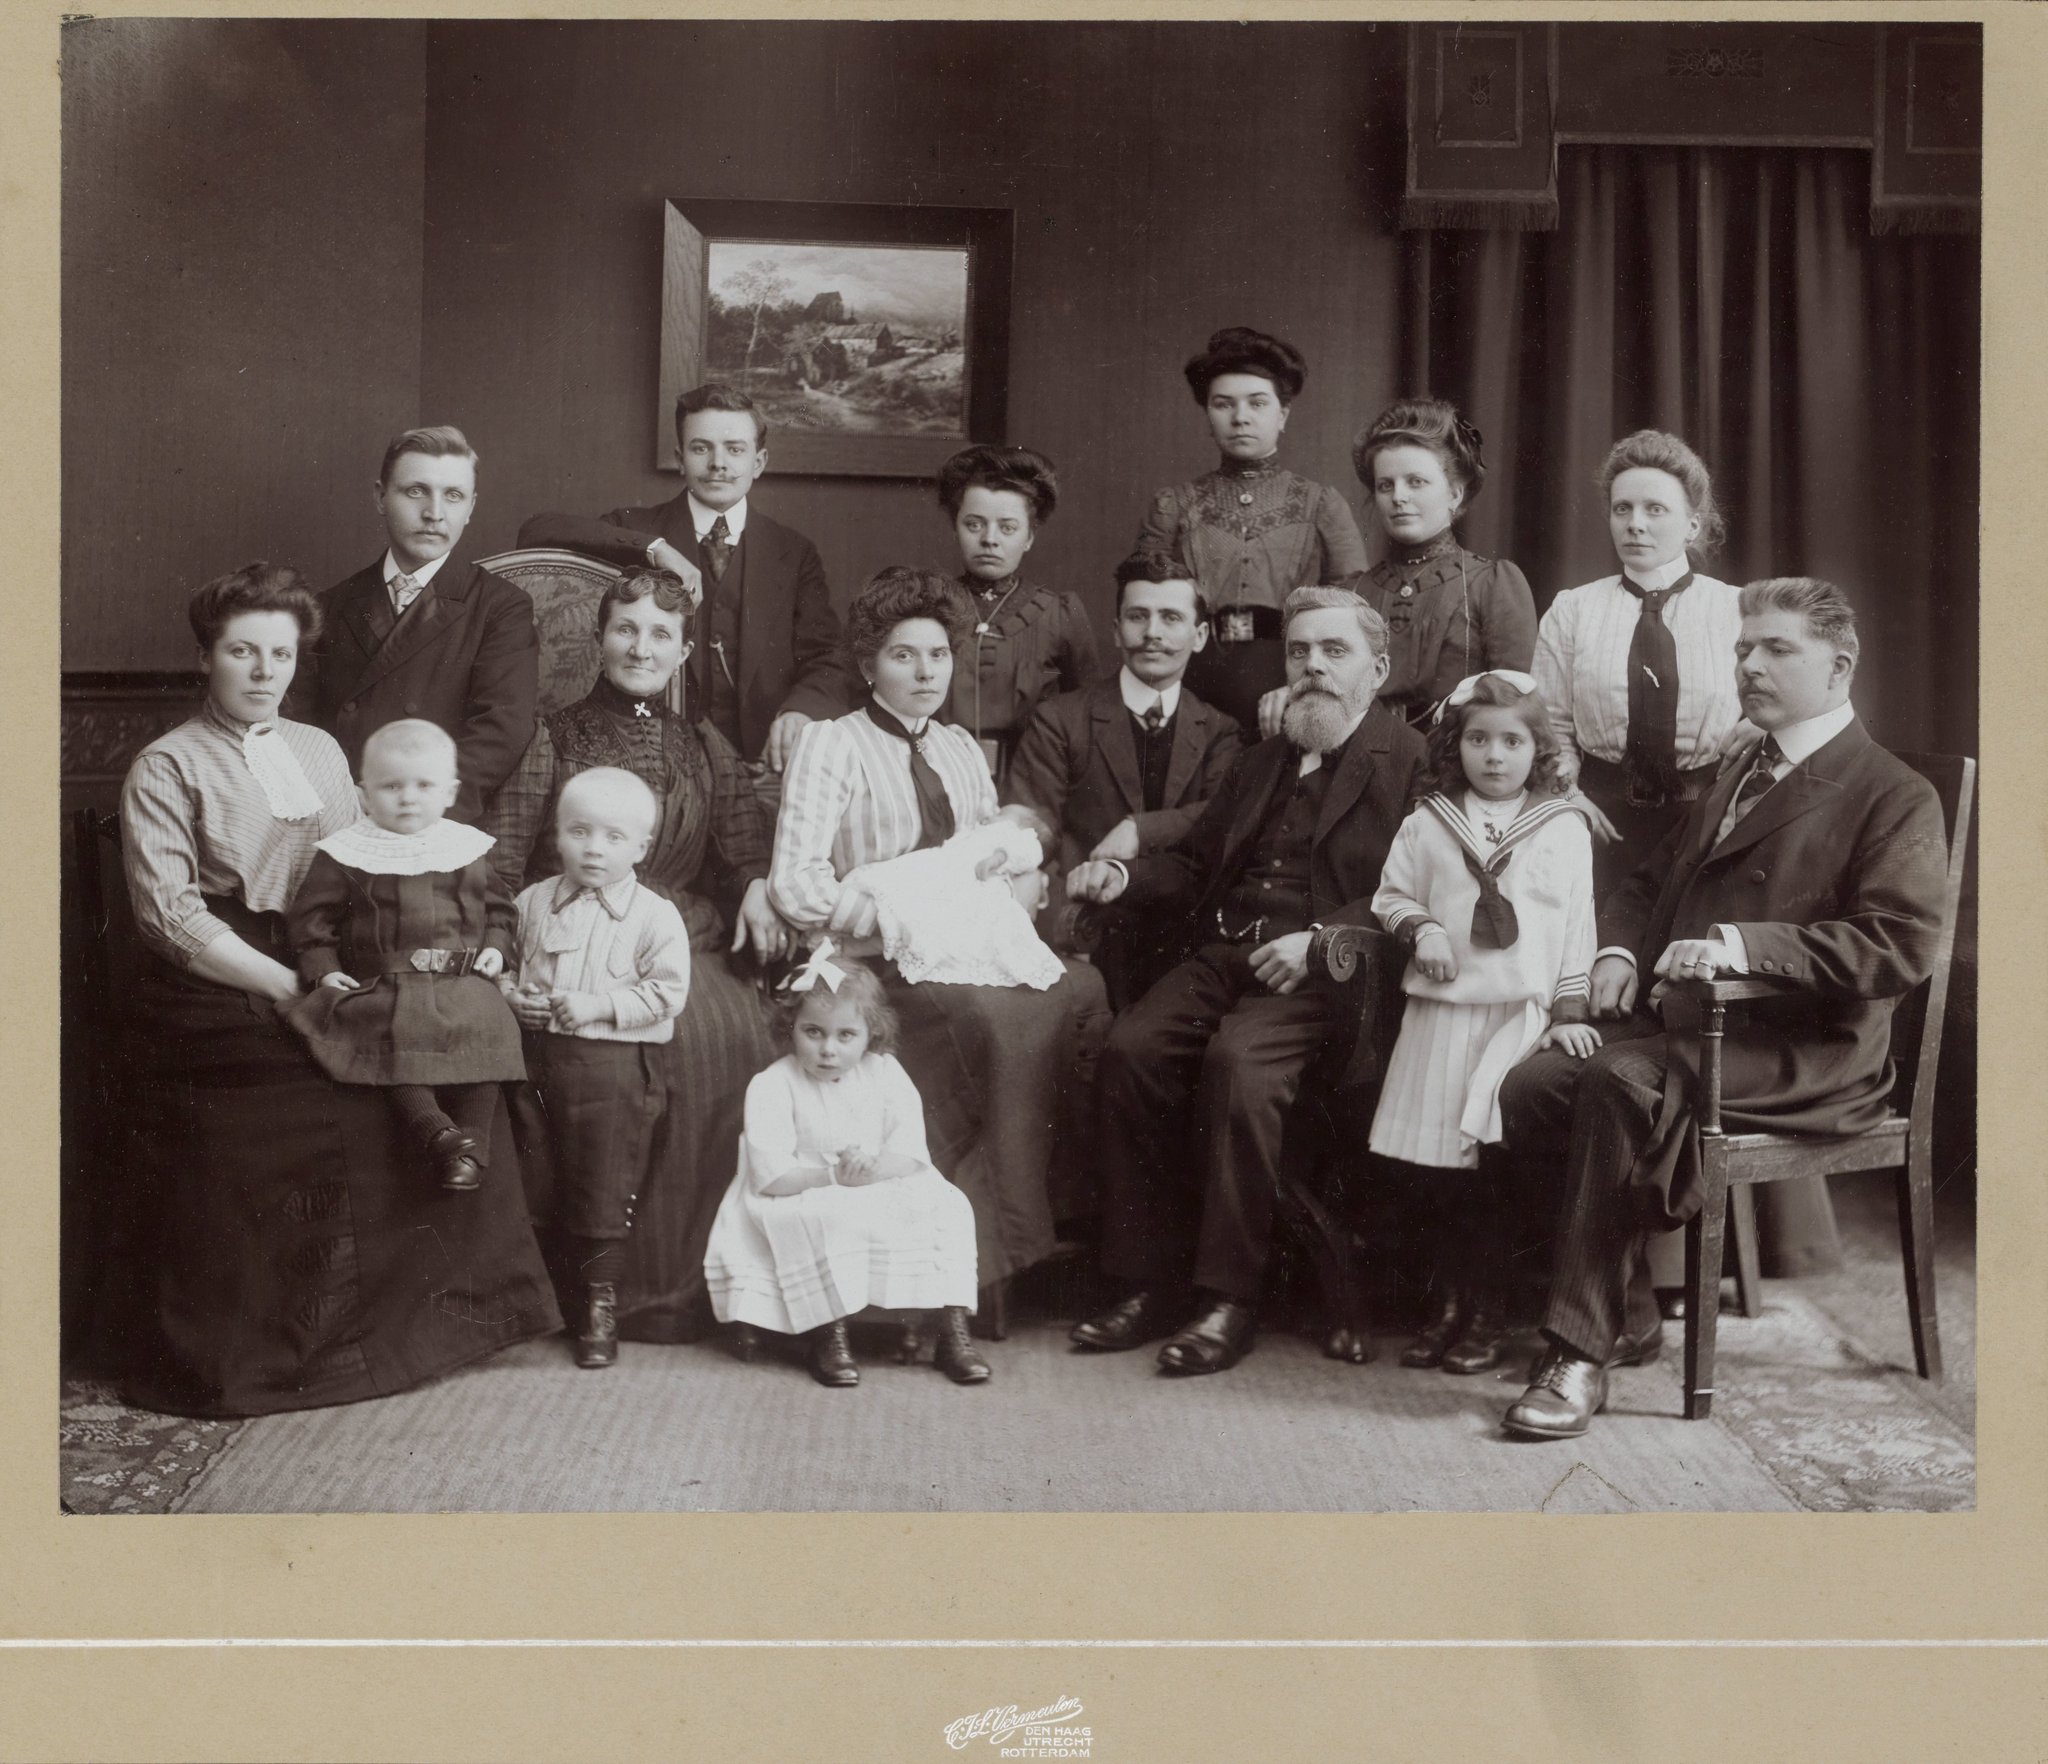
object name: photograph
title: Groepsportret van een familie in een huiskamer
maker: cornelis johannes lodewicus vermeulen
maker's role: fotograaf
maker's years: 1861-1936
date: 1890-1915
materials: cardboard, paper, photographic support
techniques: collodion silver print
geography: netherlands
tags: three generations (family group), netherlands